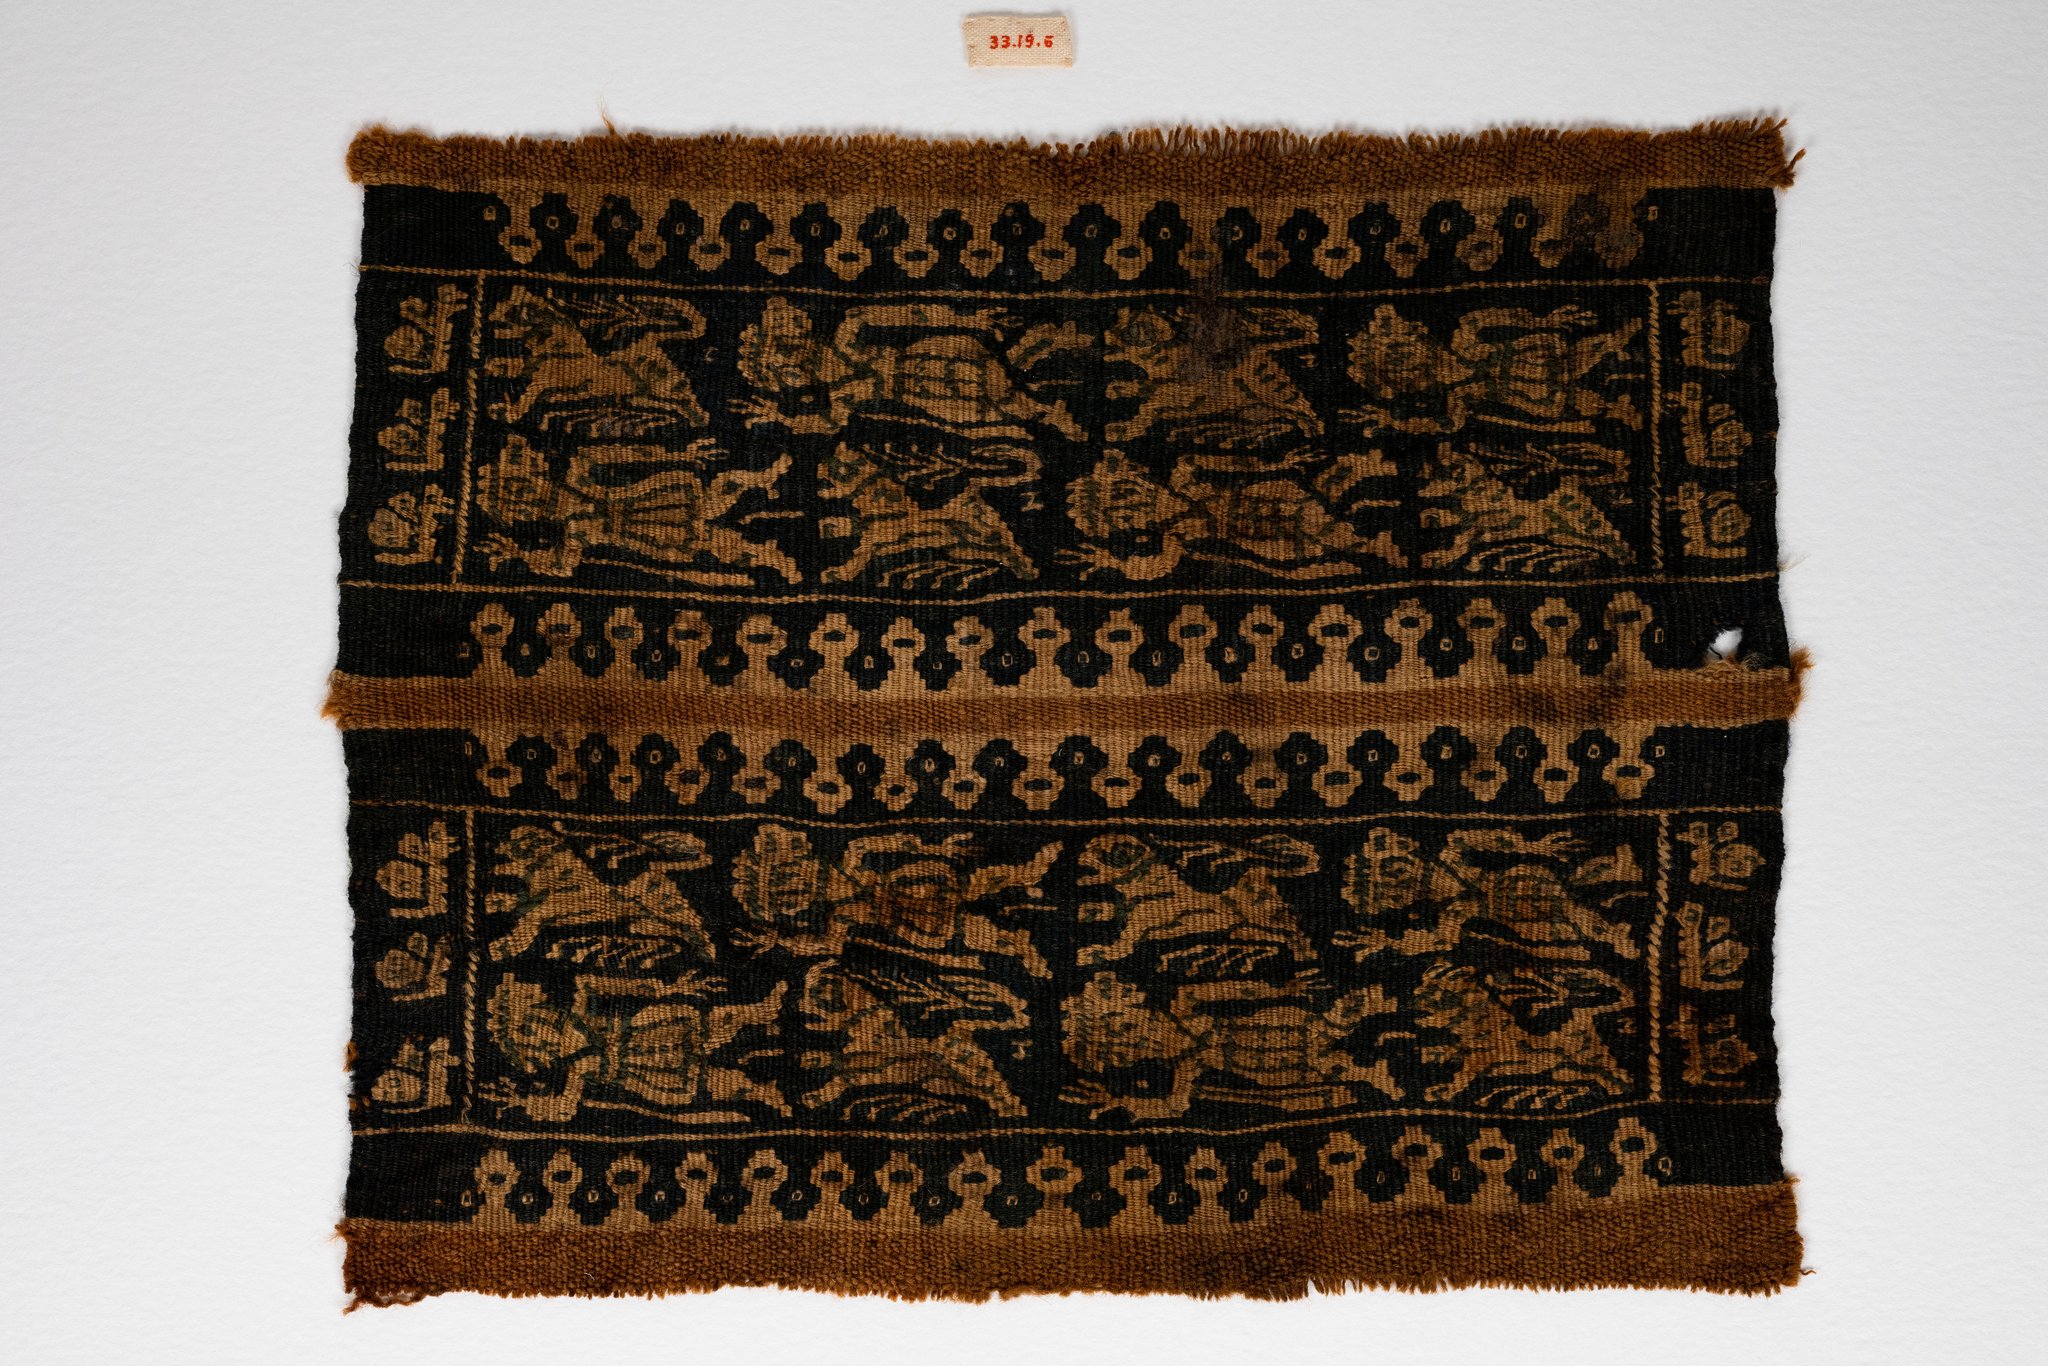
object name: textile fragment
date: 301-500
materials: wool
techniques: weave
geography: egypt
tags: animals